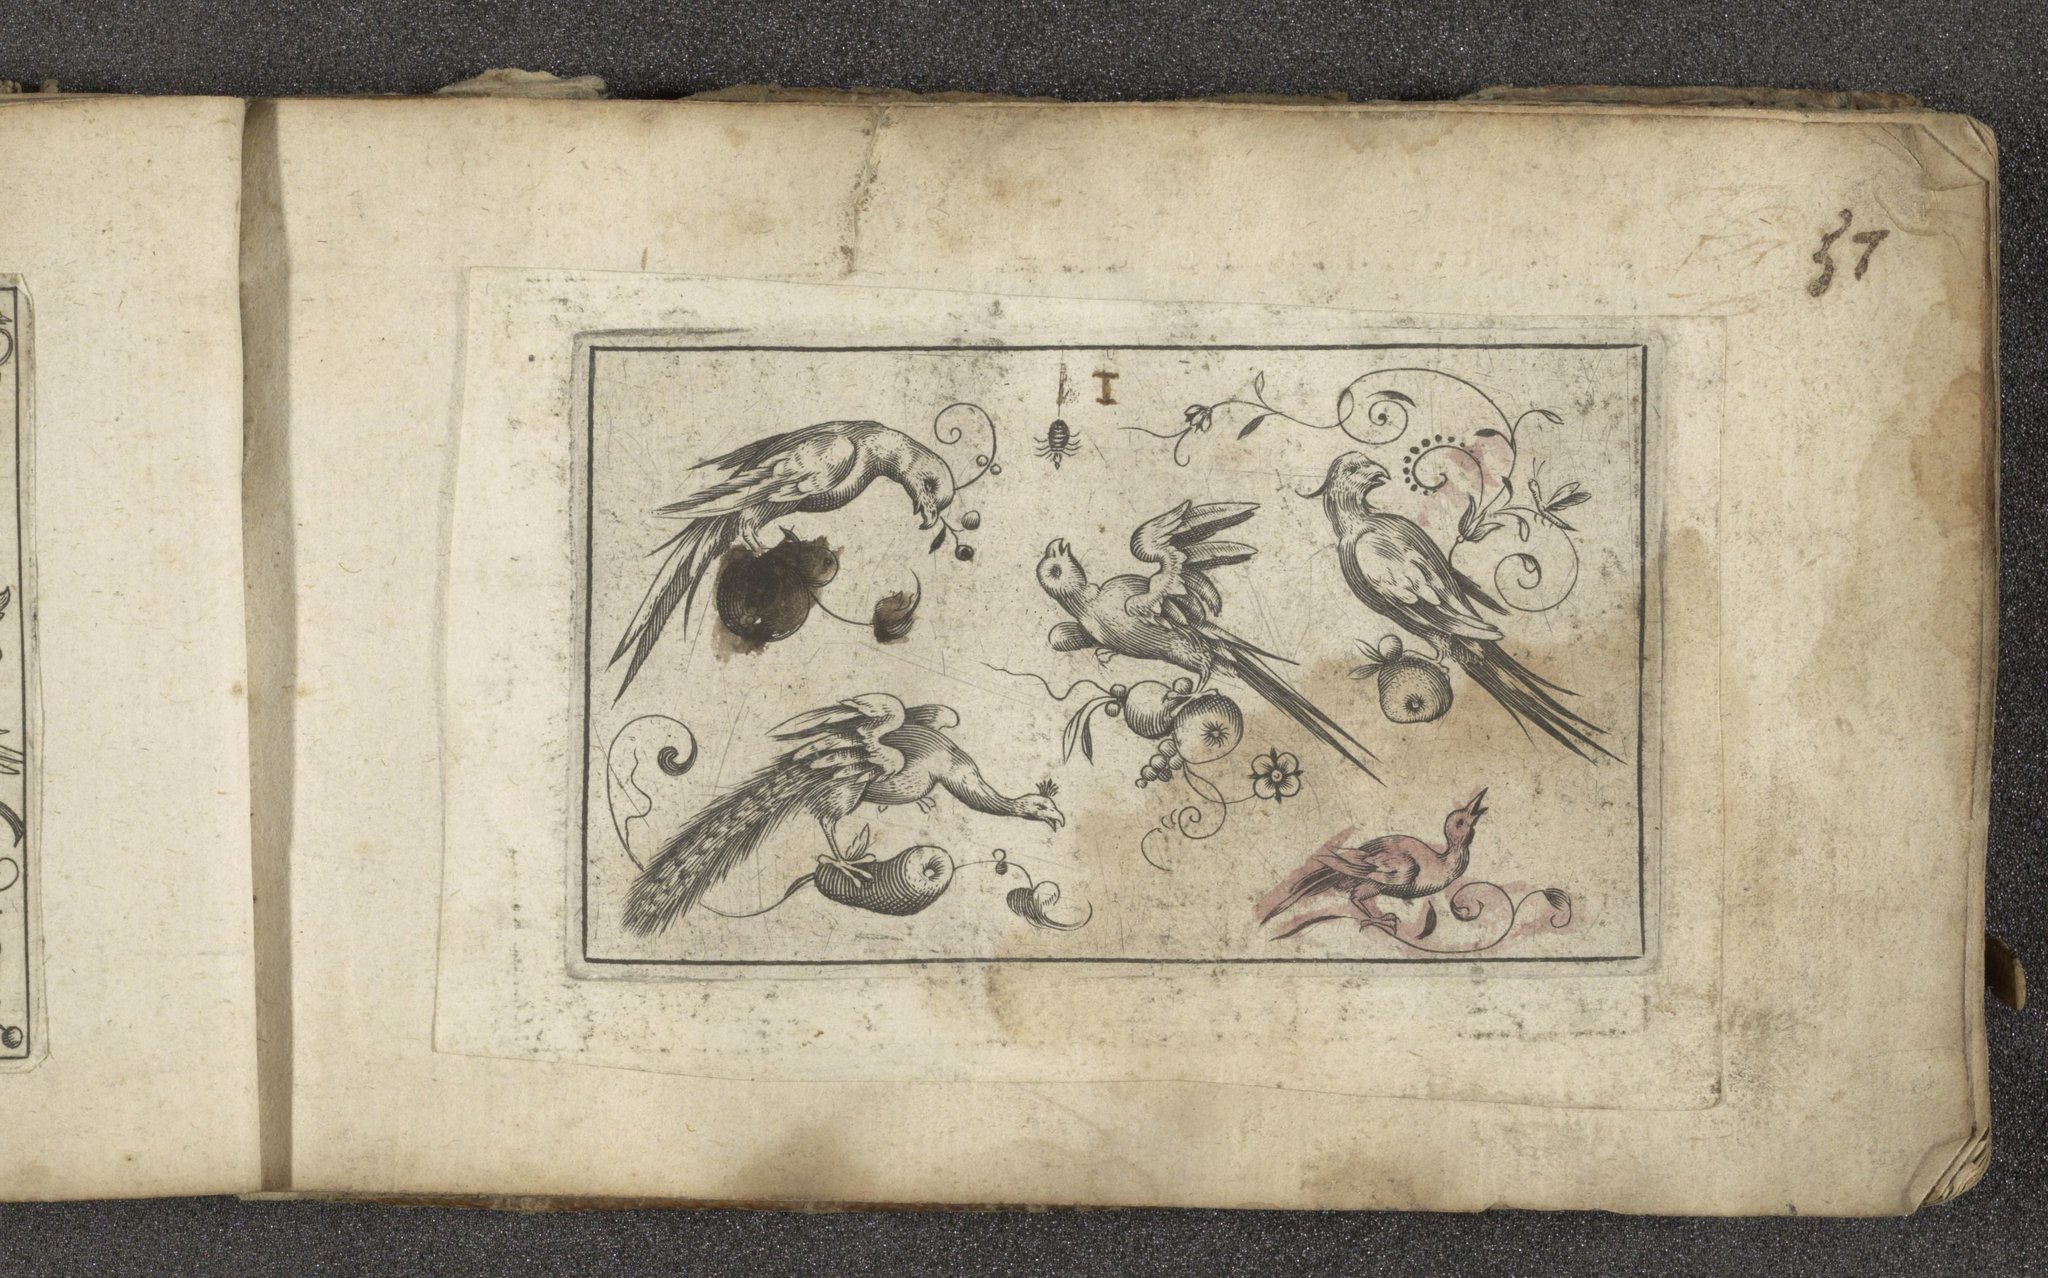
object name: print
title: Vijf vogels en een spin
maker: Anonymous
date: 1601-1650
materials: paper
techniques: colour, engraving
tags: birds, ornamental birds: peacock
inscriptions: inscription: ‘57’, inscription: ‘1’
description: Vijf vogels neergestreken op een stuk fruit of een tak. Linksonder een pauw. Bovenaan hangt een spin. De prent maakt deel uit van een album.